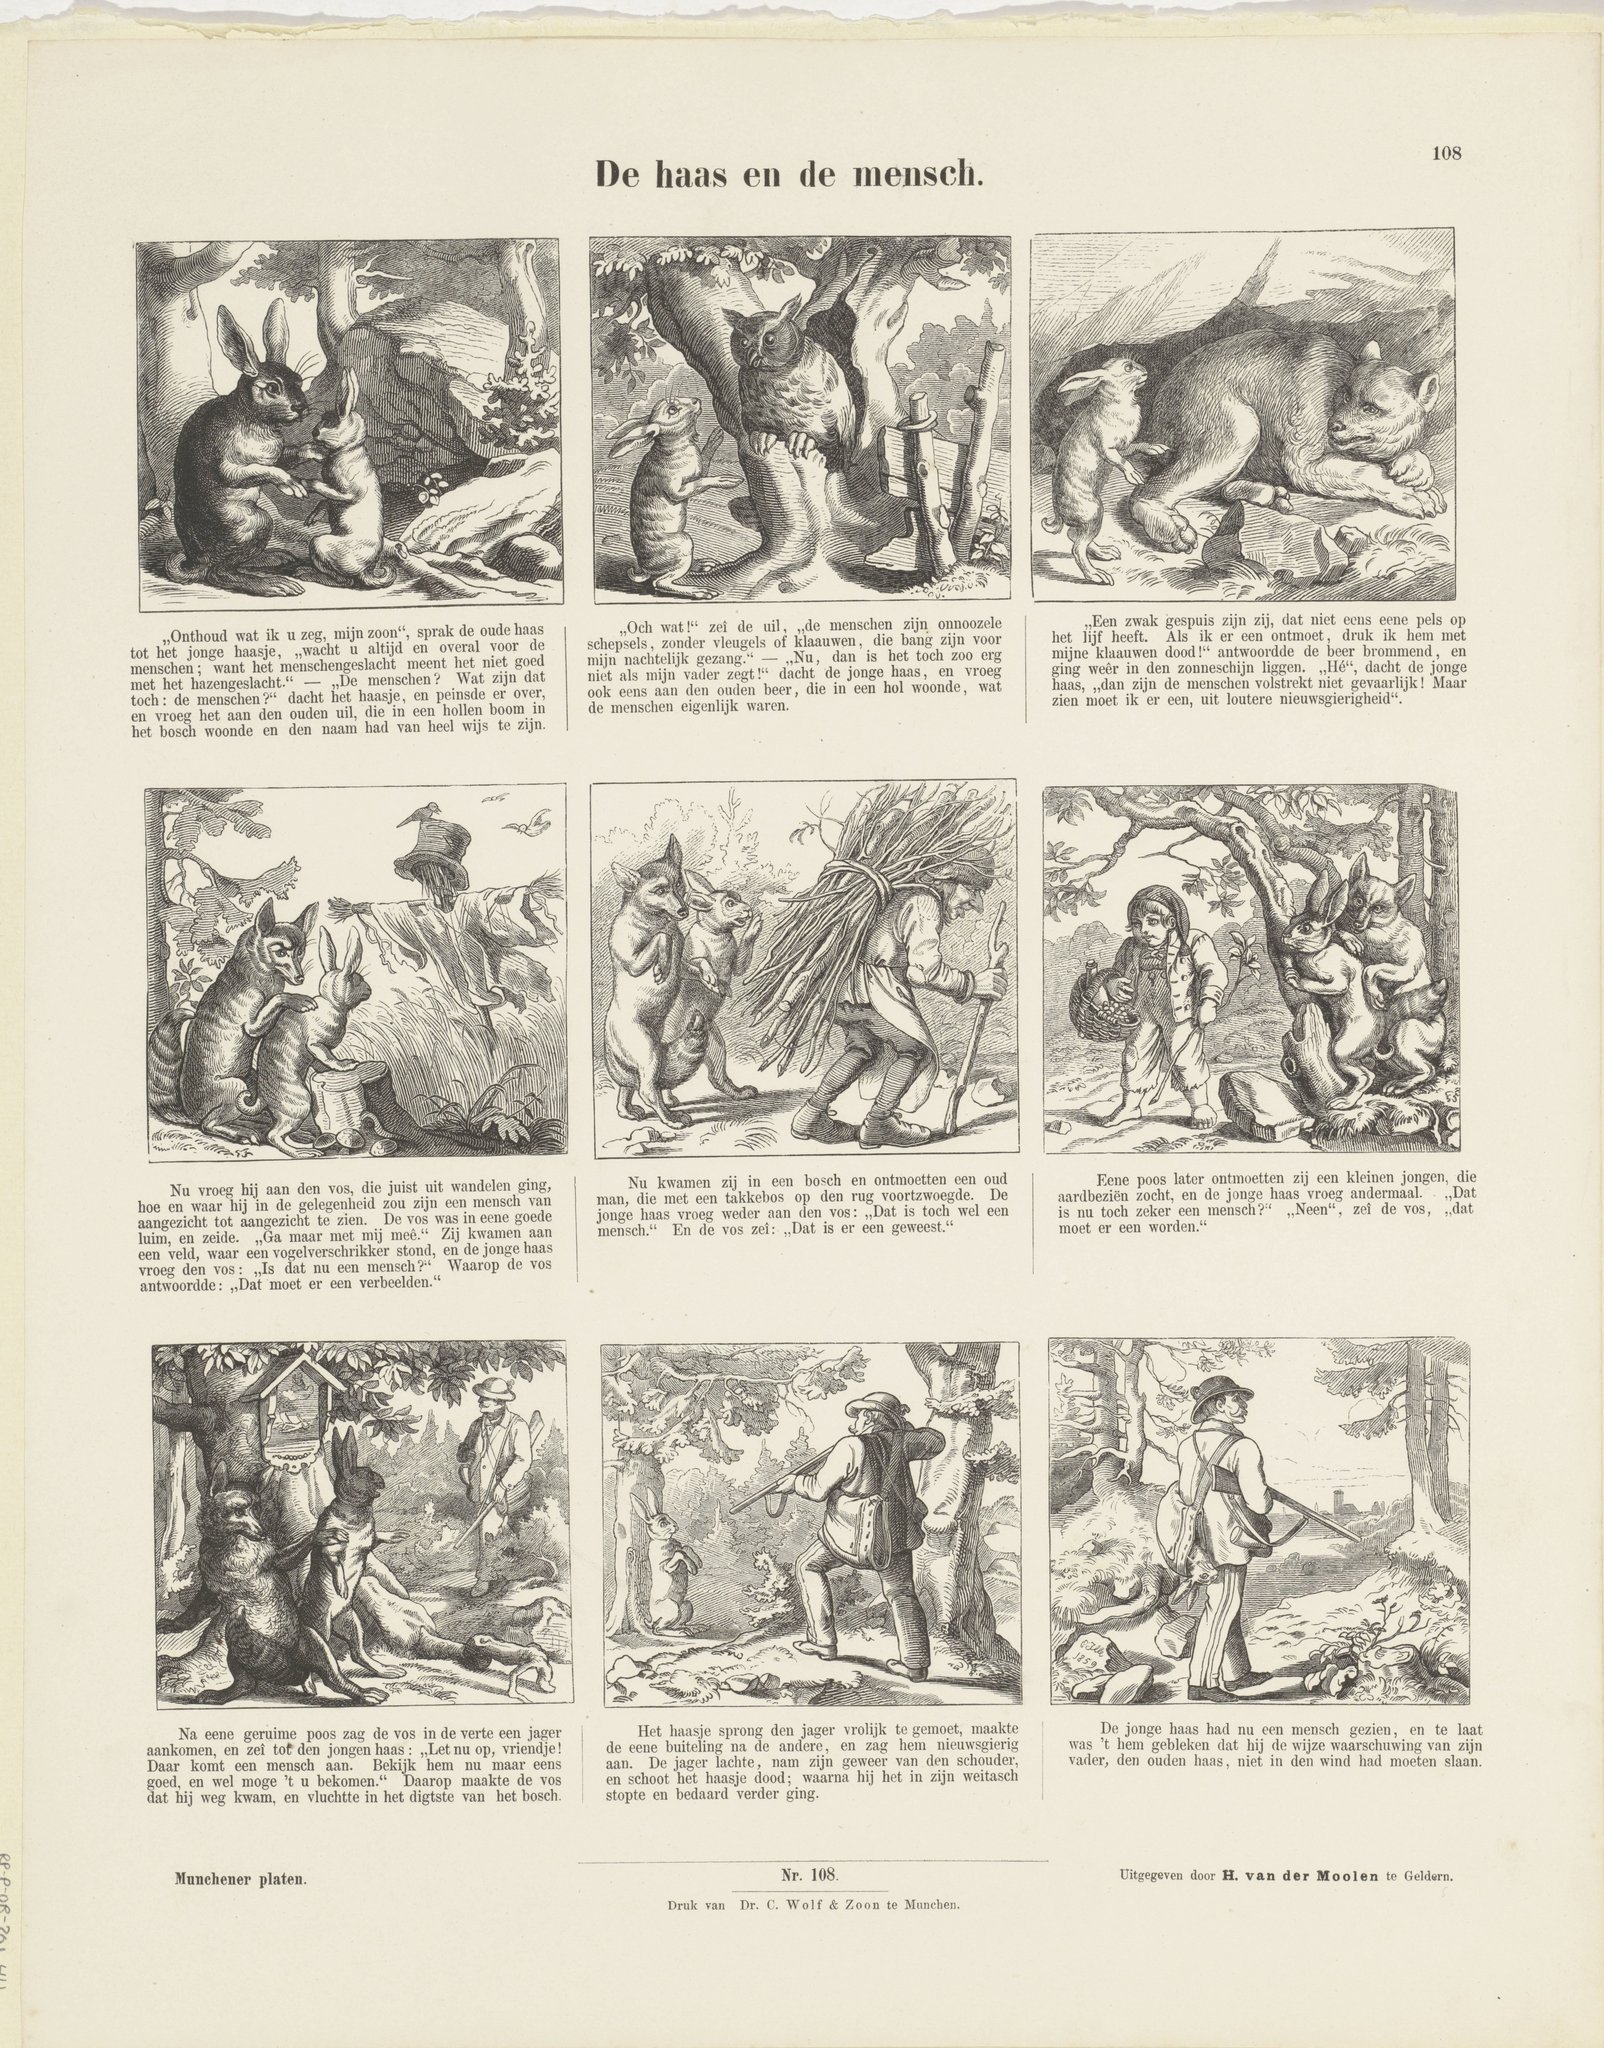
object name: print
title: De haas en de mensch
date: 1859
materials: paper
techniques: letterpress printing, engraving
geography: germany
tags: animals acting as human beings, hare-hunting, rabbit-hunting, rodents: rabbit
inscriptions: date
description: Blad met 9 voorstellingen over een haasje die de goede raad van zijn vader niet ter harte neemt en uiteindelijk wordt neergeschoten door een jager. Onder elke voorstelling een onderschrift. Genummerd midden onder: Nro. 108. Genummerd rechtsboven: 108.